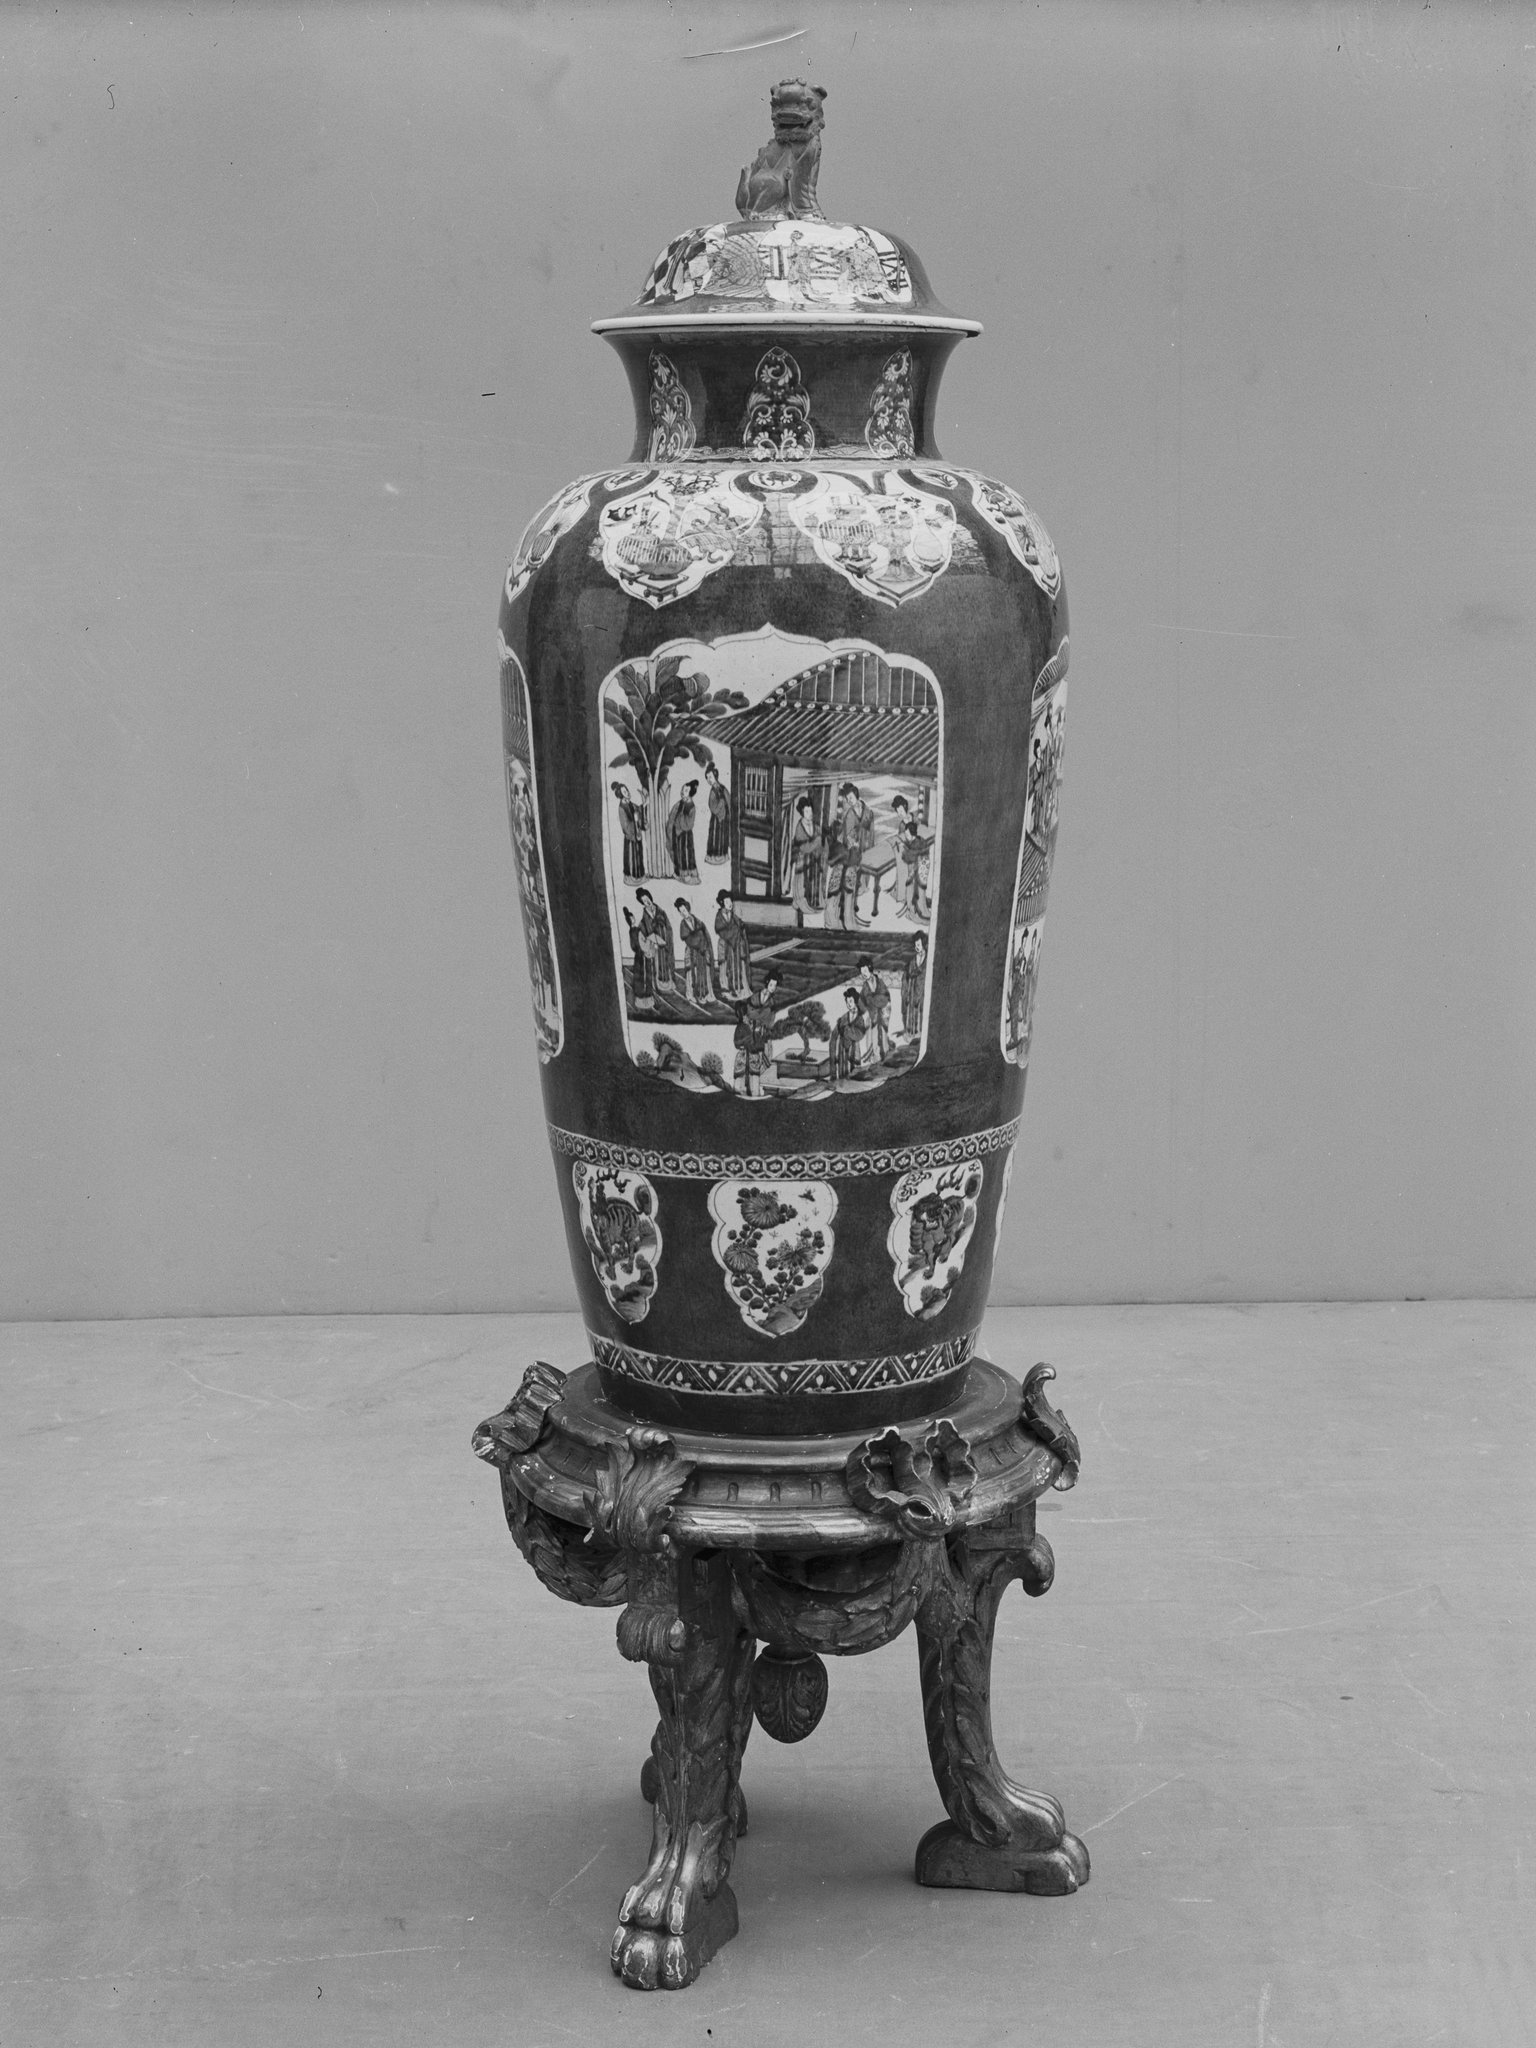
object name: covered jar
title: Covered jar with ladies and antiques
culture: chinese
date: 1667-1733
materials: cobalt, porcelain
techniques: painting, underglaze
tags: animals,houses,women,trees